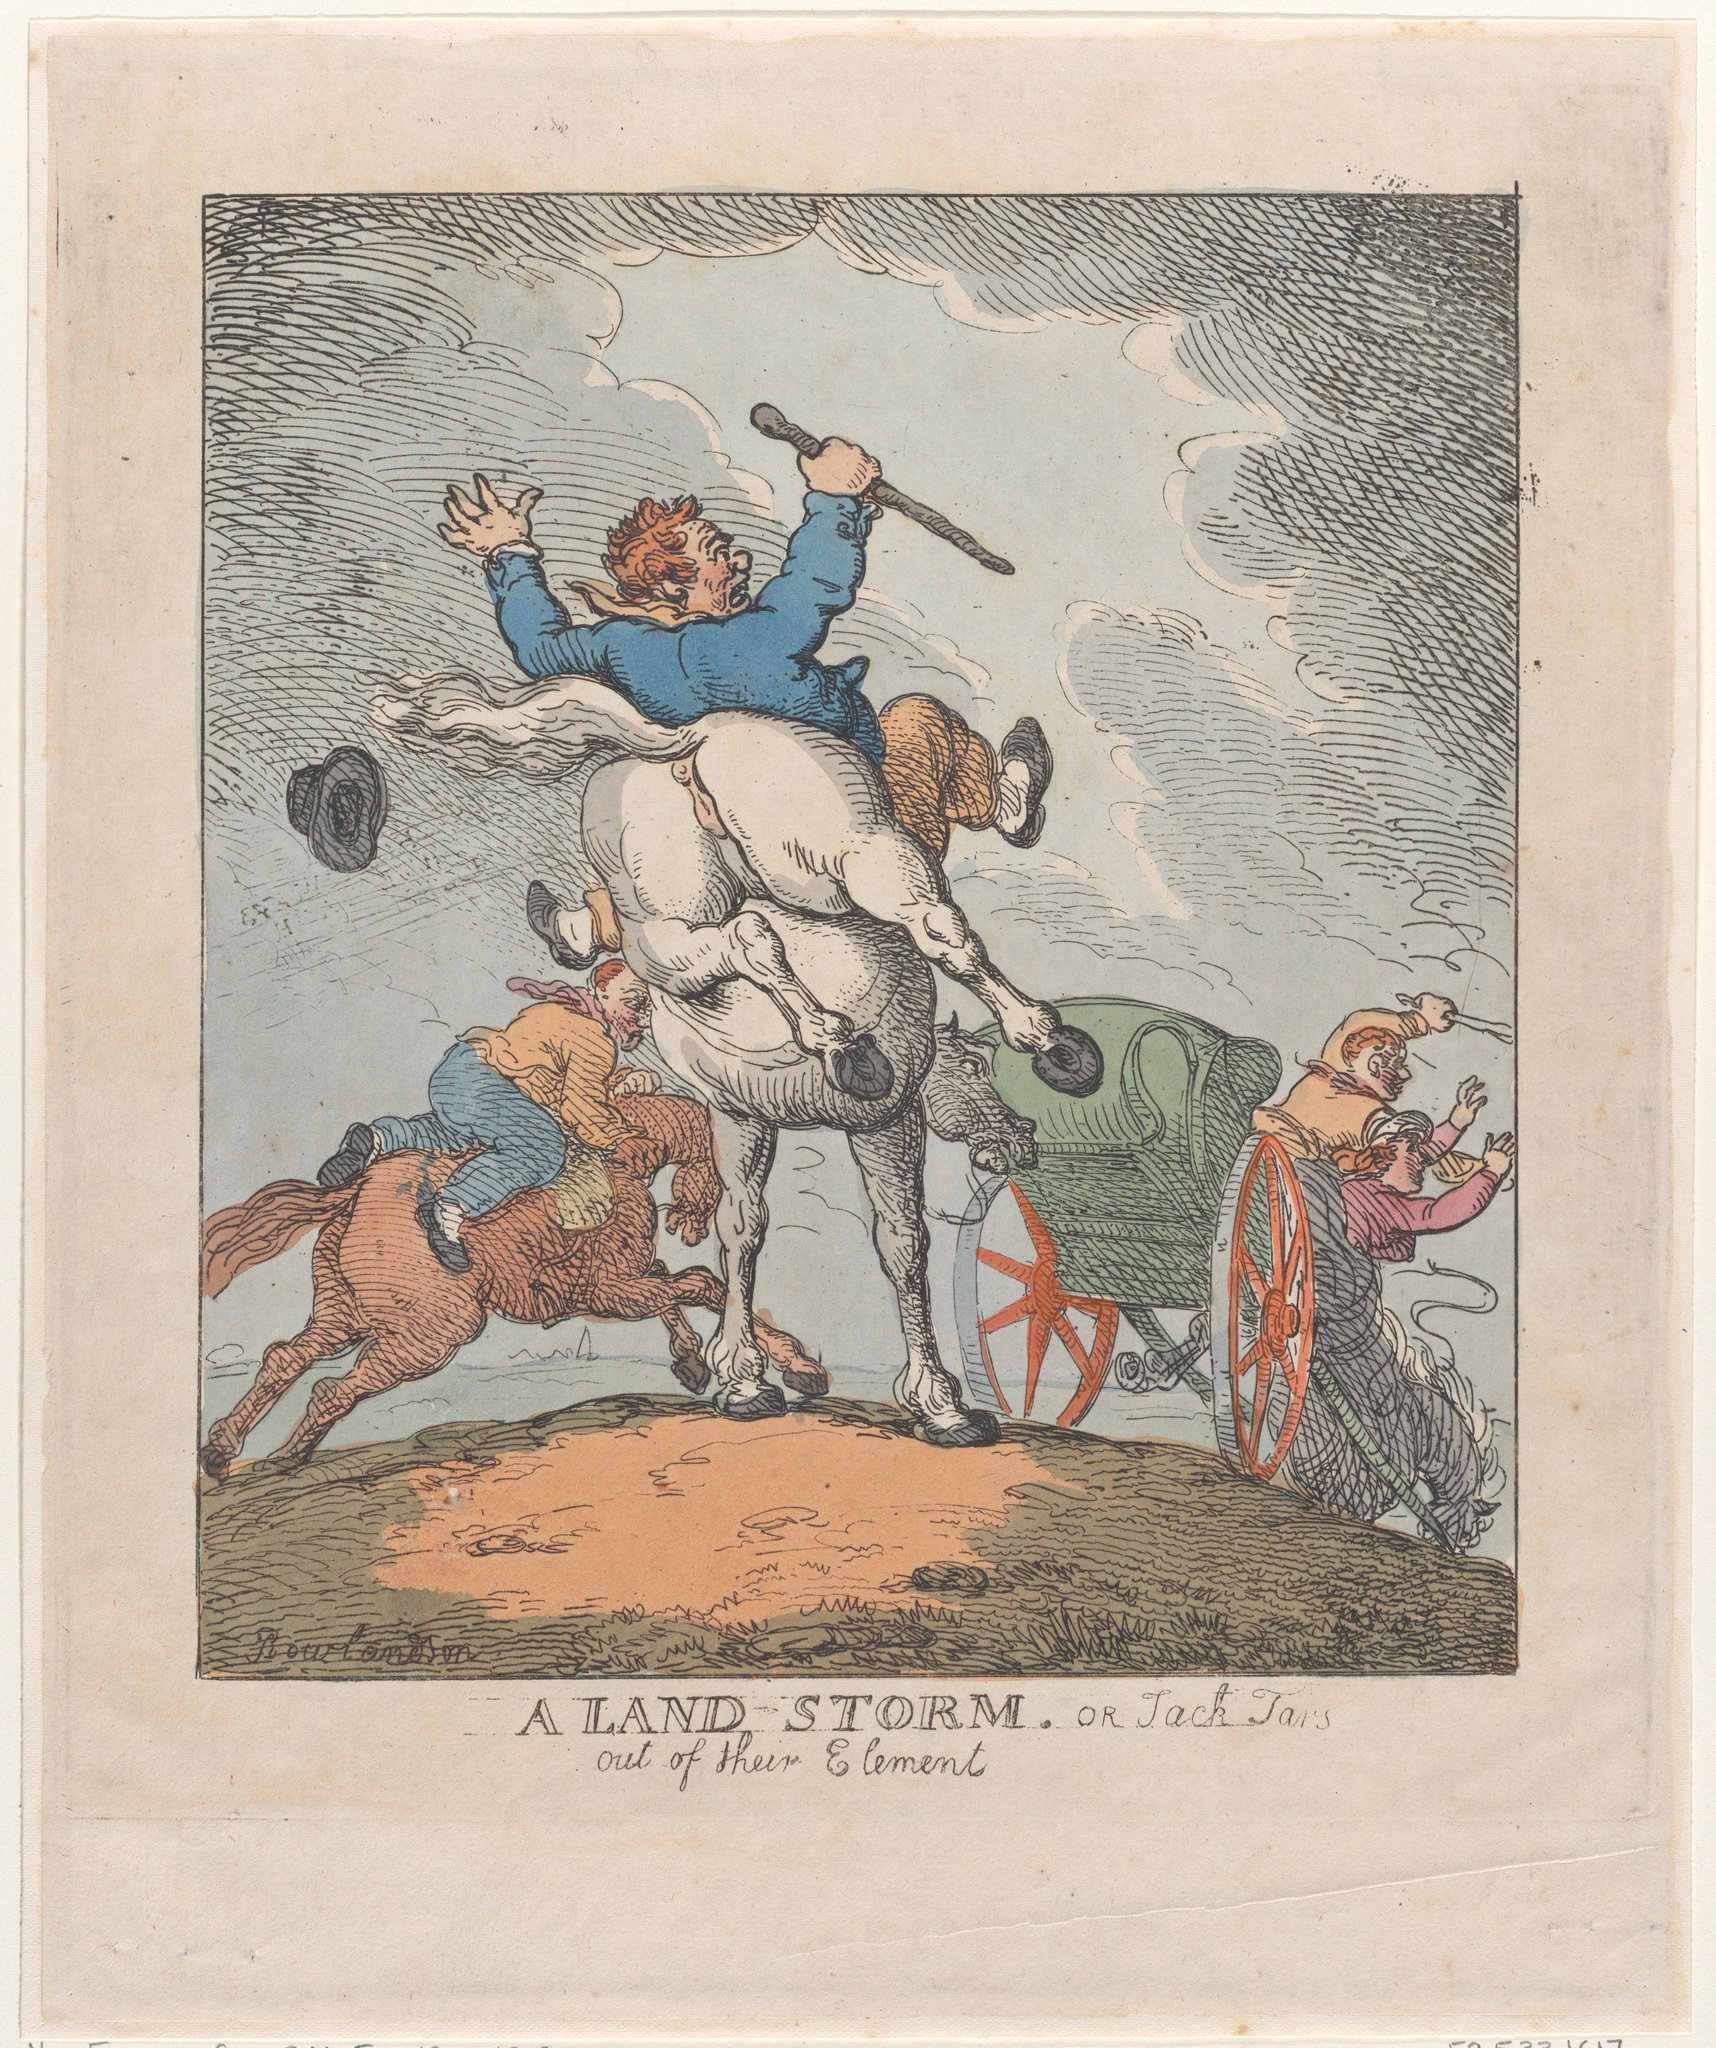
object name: print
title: A Land Storm, or Jack Tars Out of Their Element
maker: thomas rowlandson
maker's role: artist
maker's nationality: british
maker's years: 1757-1827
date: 1790-1815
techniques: etching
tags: satire,men,horses,carriages